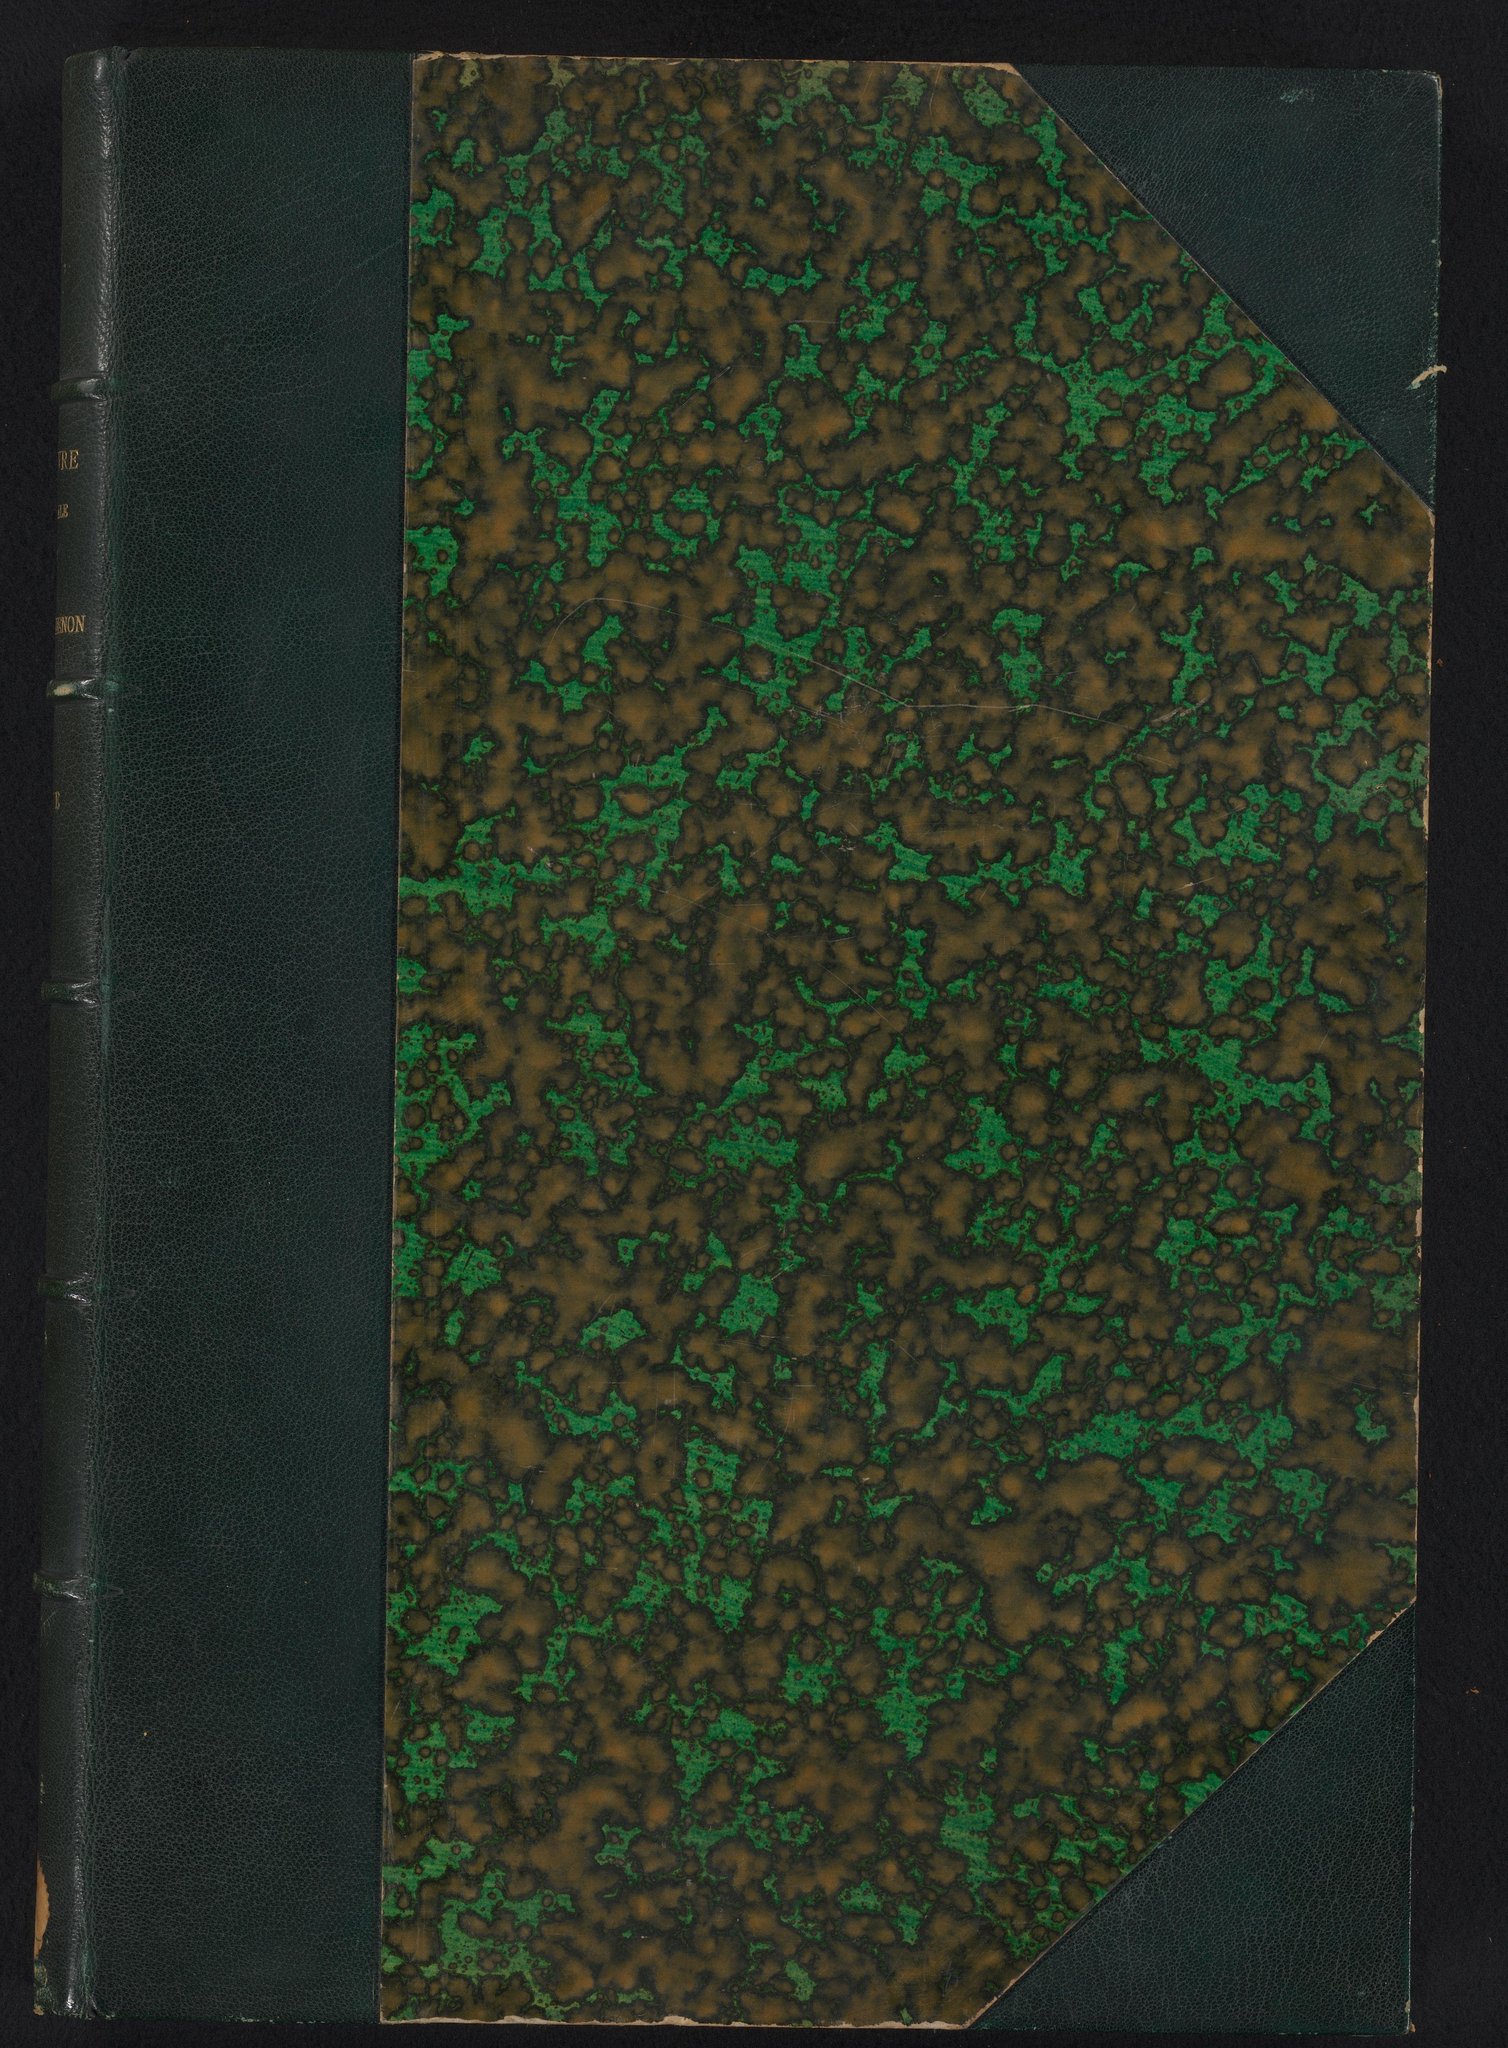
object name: book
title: Album met het oeuvre van Dominique Vivant Denon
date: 1873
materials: cardboard, leather, paper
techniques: bookbinding, marbled paper, letterpress printing, photochemical processes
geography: paris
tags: head (human), boy (child between toddler and youth), historical persons, don quixote, beggar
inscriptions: number: ‘232-1’, watermark, collector's mark: Lugt 948a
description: Album met 117 fotomechanische reproducties van prenten op 161 bladen met in totaal zes vrije schutbladen, en een ex libris op één van de vrije schutbladen. Het album bevat reproducties, waarschijnlijk heliogravures, van prenten uit het oeuvre van Denon, verdeeld over twee delen. Dit album betreft deel 1. De reproducties zijn in het album geplakt, gebonden en er los in gelegd. Dit album betreft nummer 3 uit een oplage van 48.